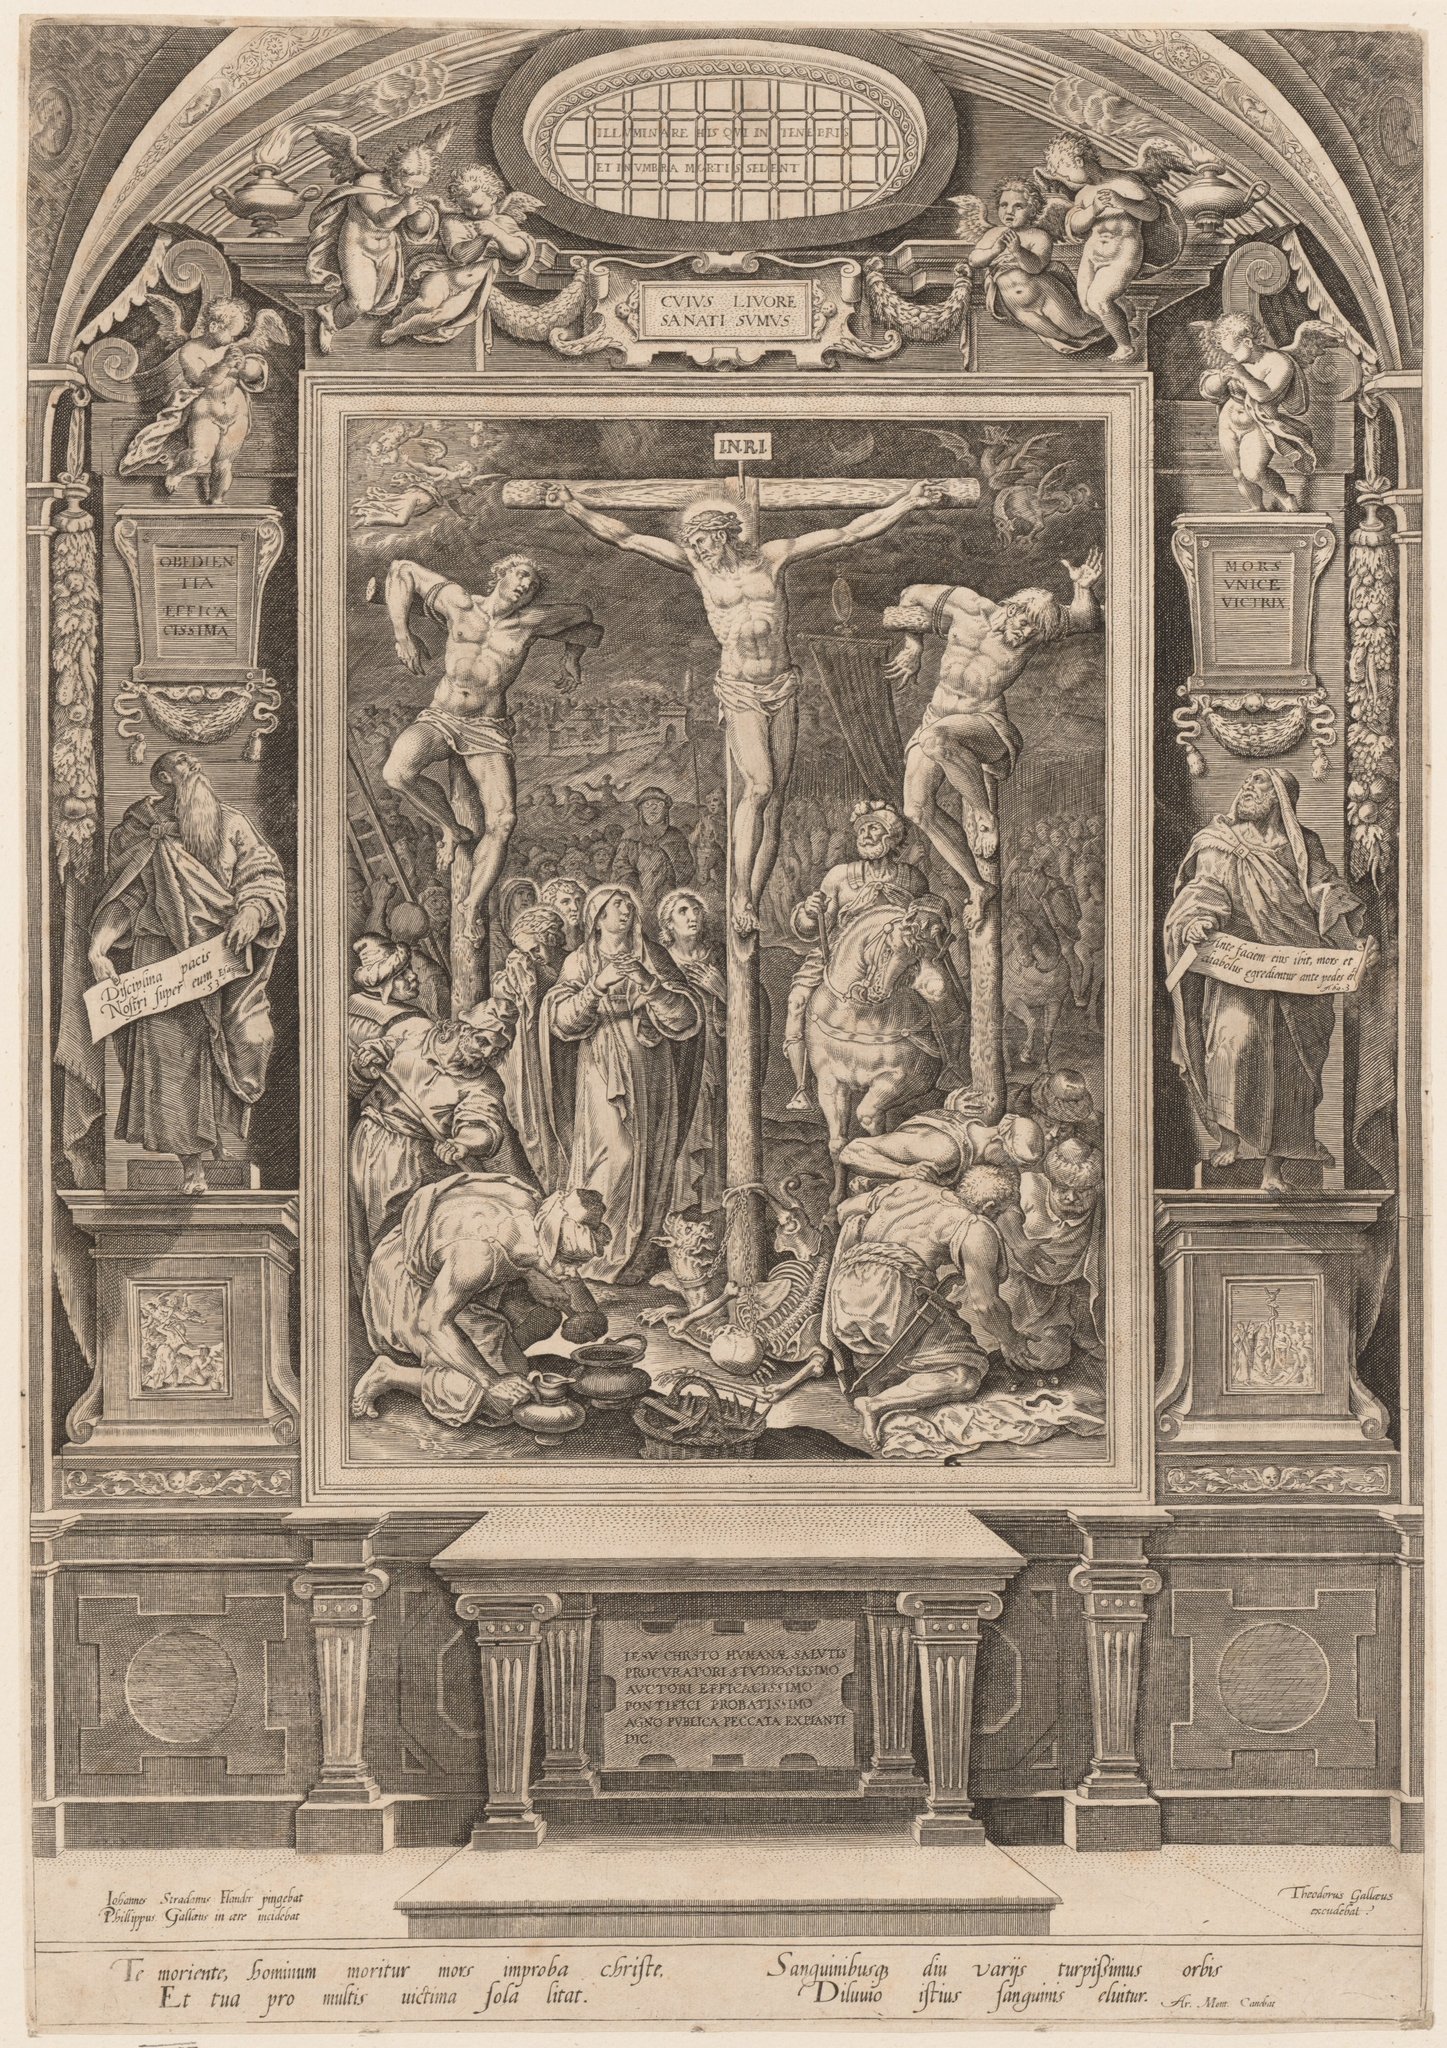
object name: print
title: Christ on the Cross between Two Thieves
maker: philips galle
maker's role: artist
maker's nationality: netherlandish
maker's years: 1537-1612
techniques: engraving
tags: men,women,angels,christ,cross